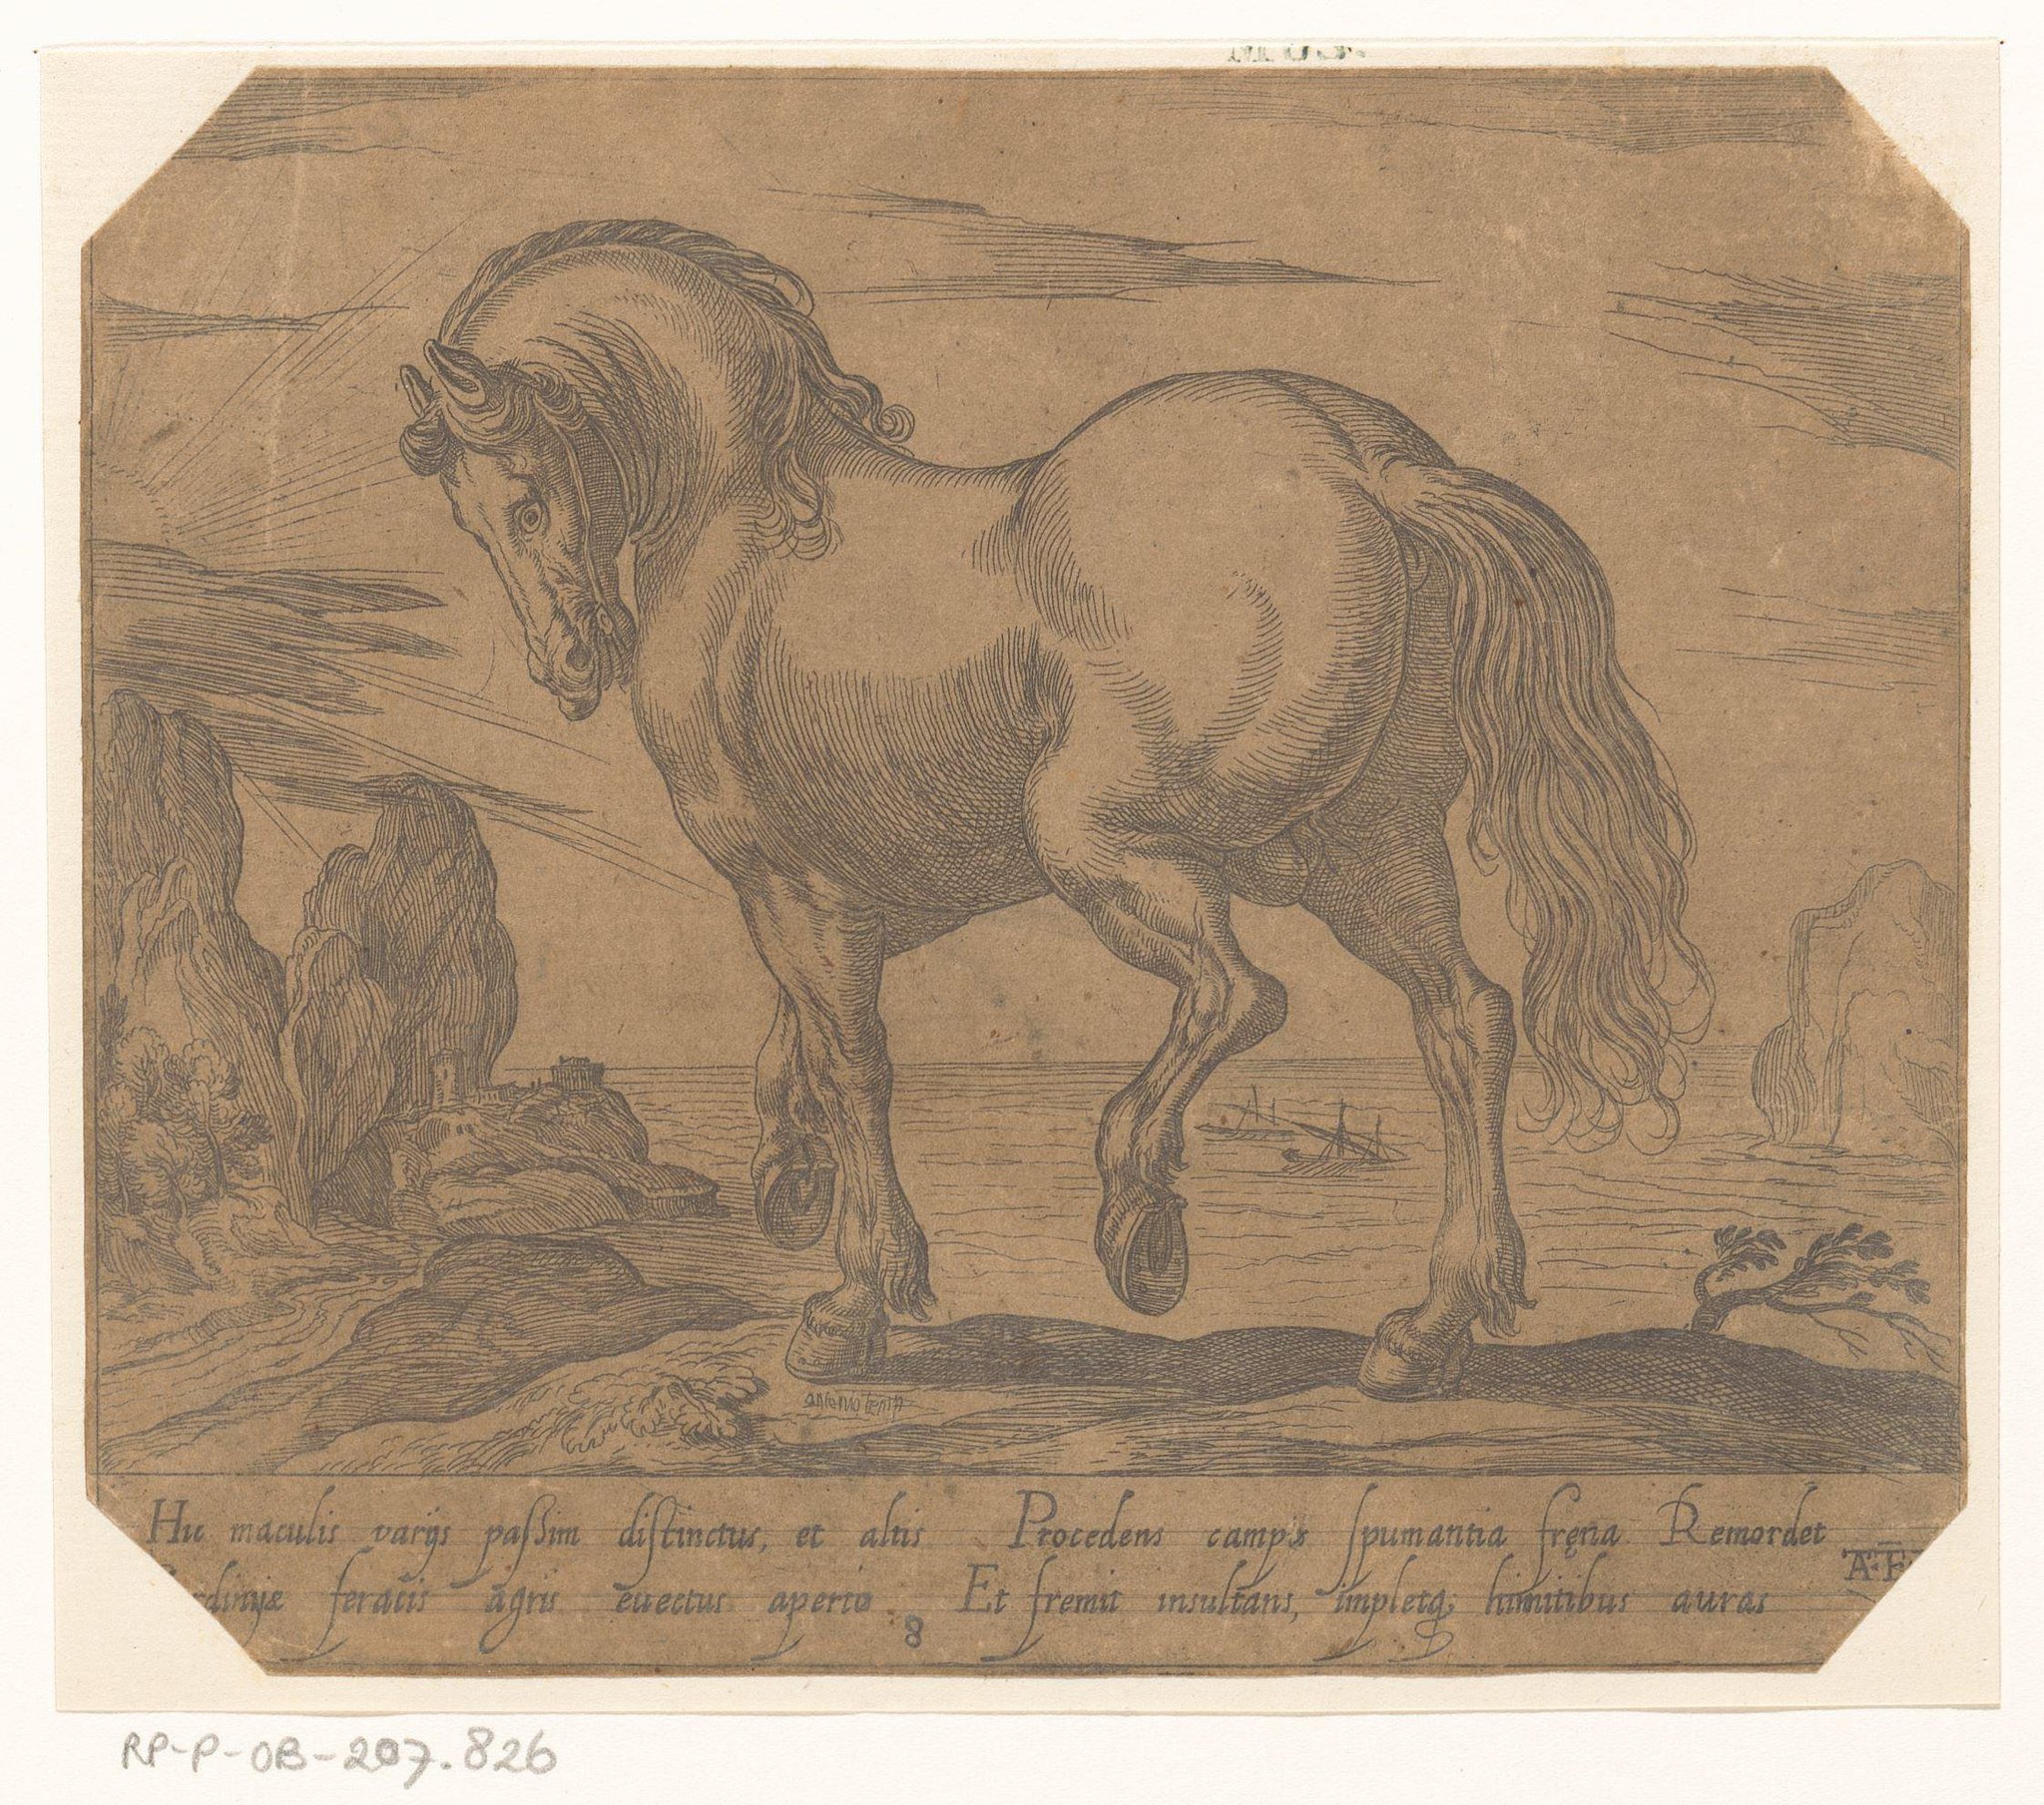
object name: print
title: Staand paard naar links gewend, voor een zeegezicht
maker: antonio tempesta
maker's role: draughtsman, painter, print maker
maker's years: 1555-1630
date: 1590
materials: paper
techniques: etching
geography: italy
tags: horse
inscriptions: collector's mark: Lugt 2228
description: Deze prent maakt deel uit van een reeks van 28 prenten van paarden (+ titelprent en opdracht).